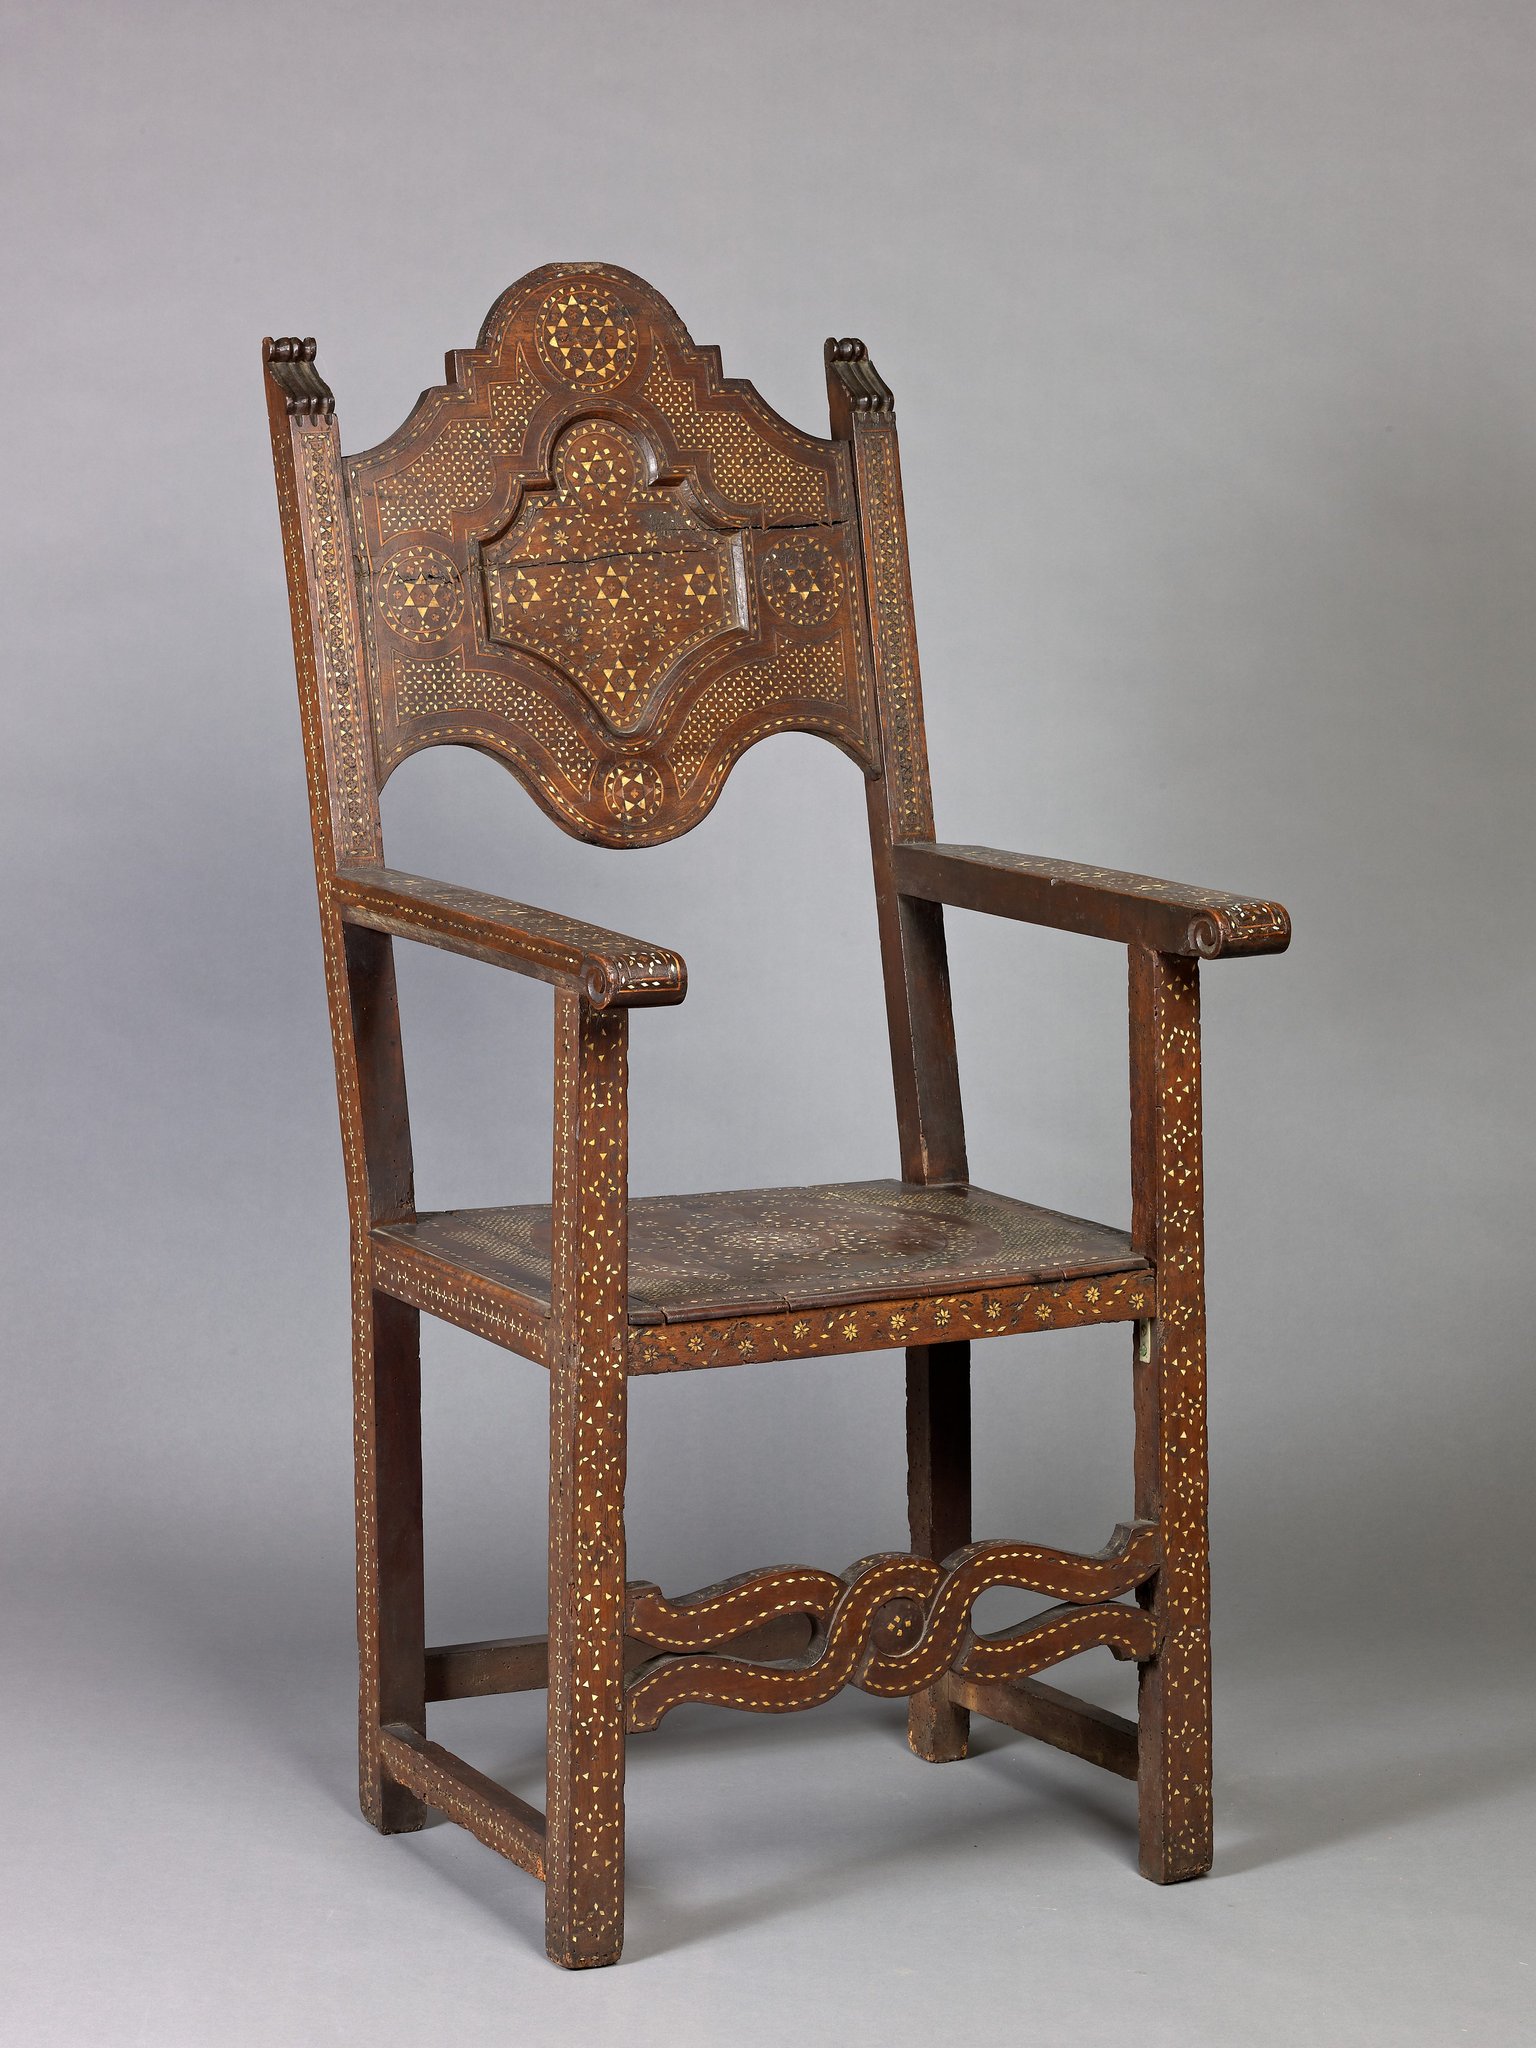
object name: armchair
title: High-back chair (pair with 1975.1.1999)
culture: north african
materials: bone, ivory